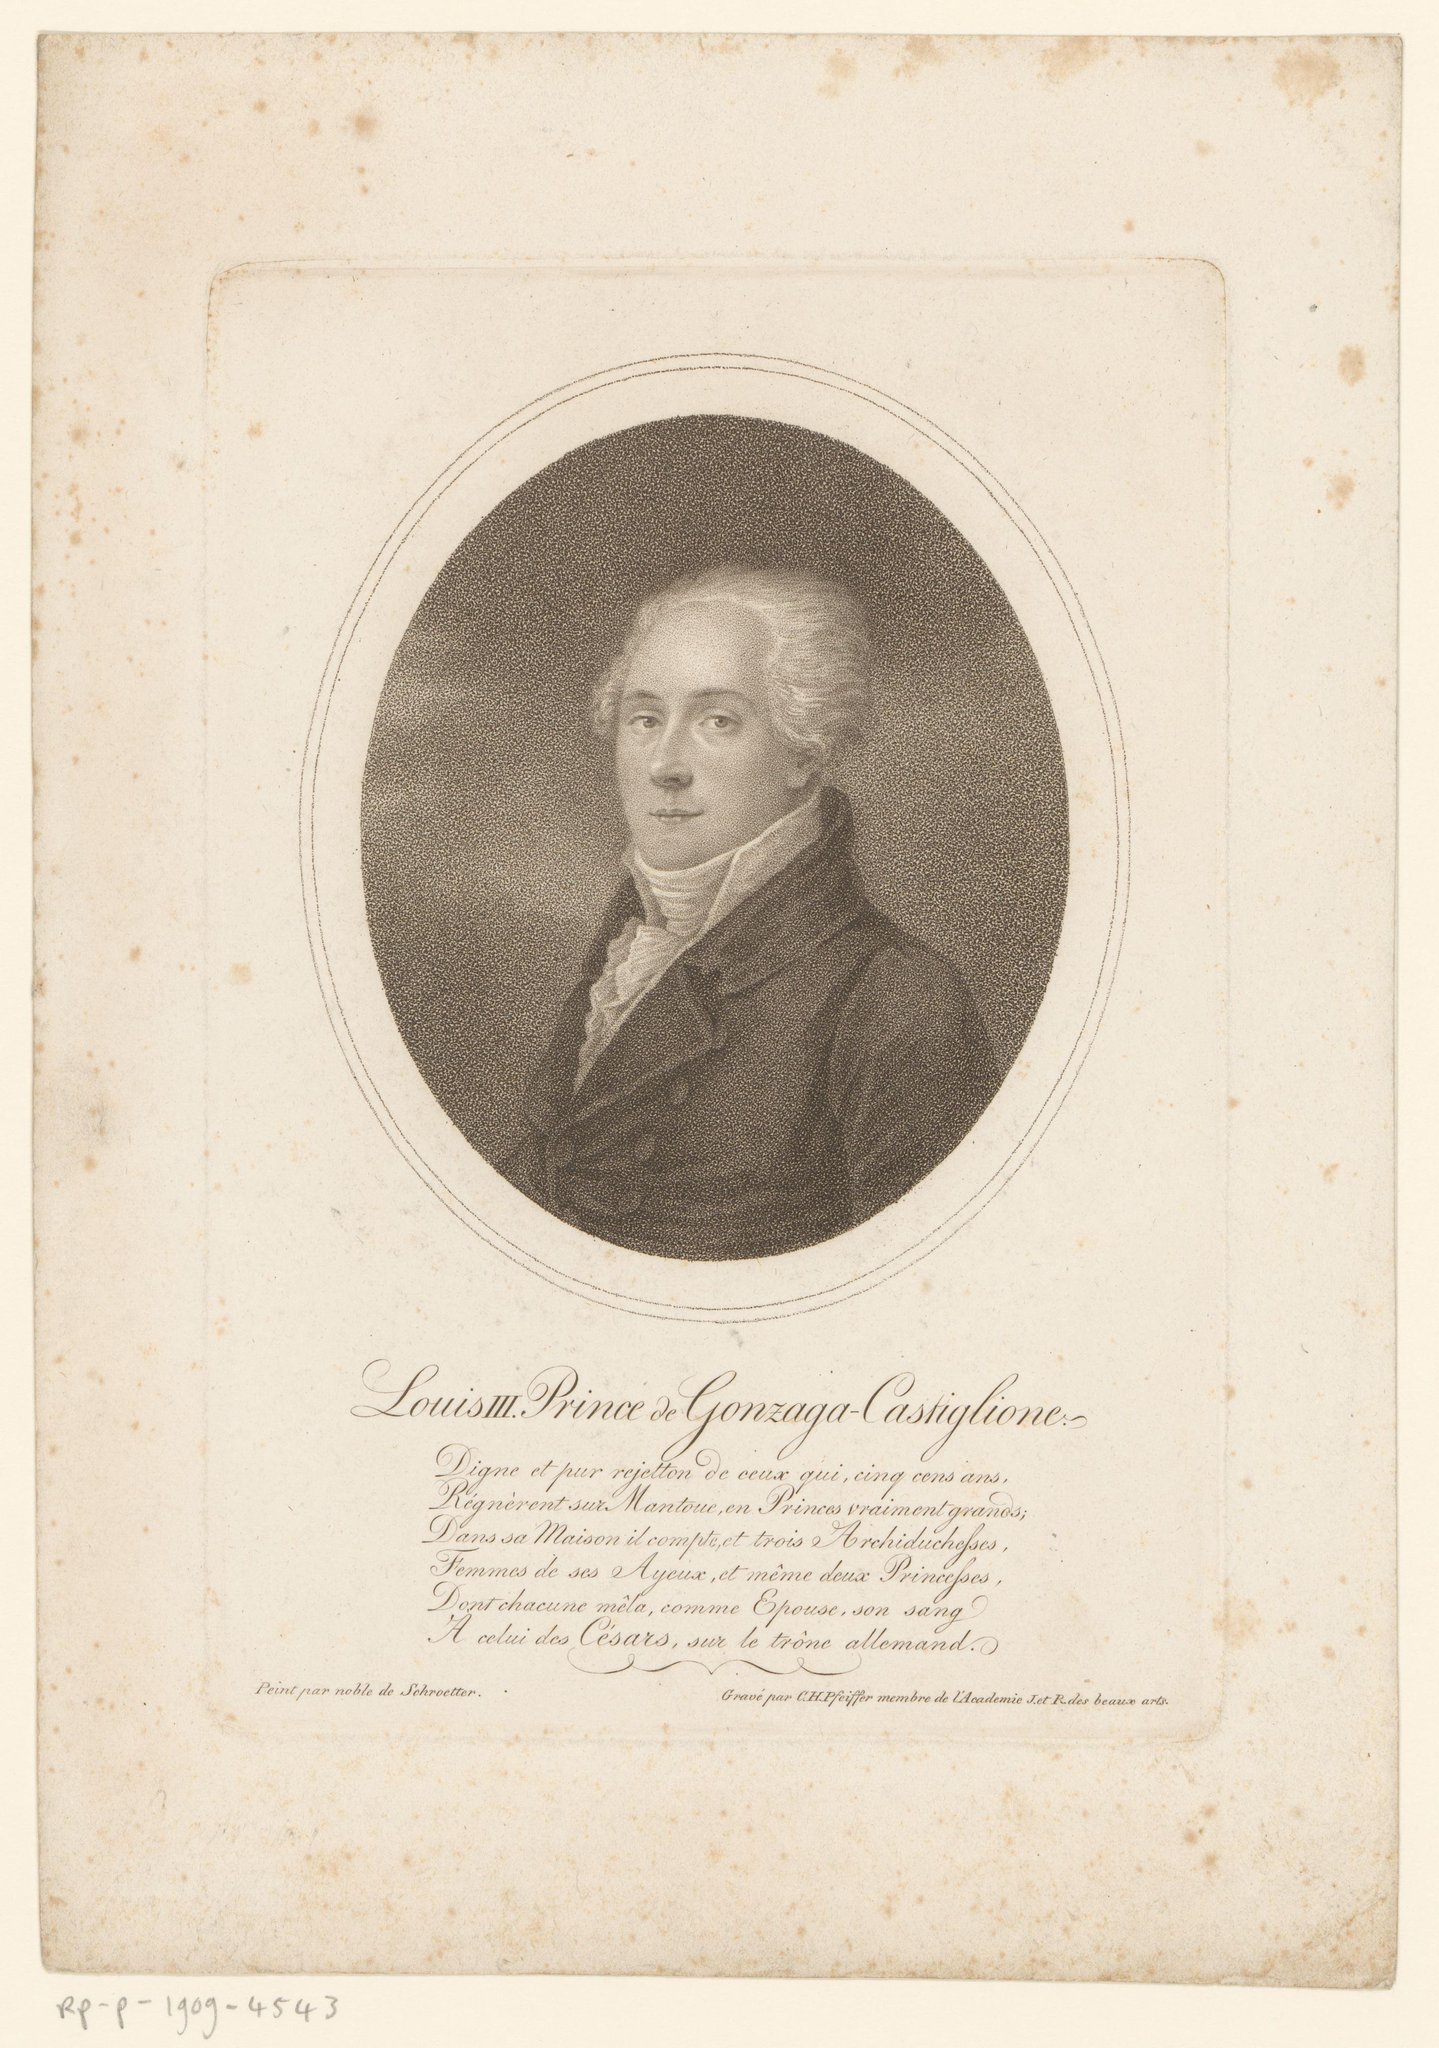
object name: print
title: Portret van Luigi di Gonzaga-Castiglione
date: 1779-1829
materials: paper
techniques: engraving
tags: venice, vienna, historical persons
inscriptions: collector's mark: Lugt 2228